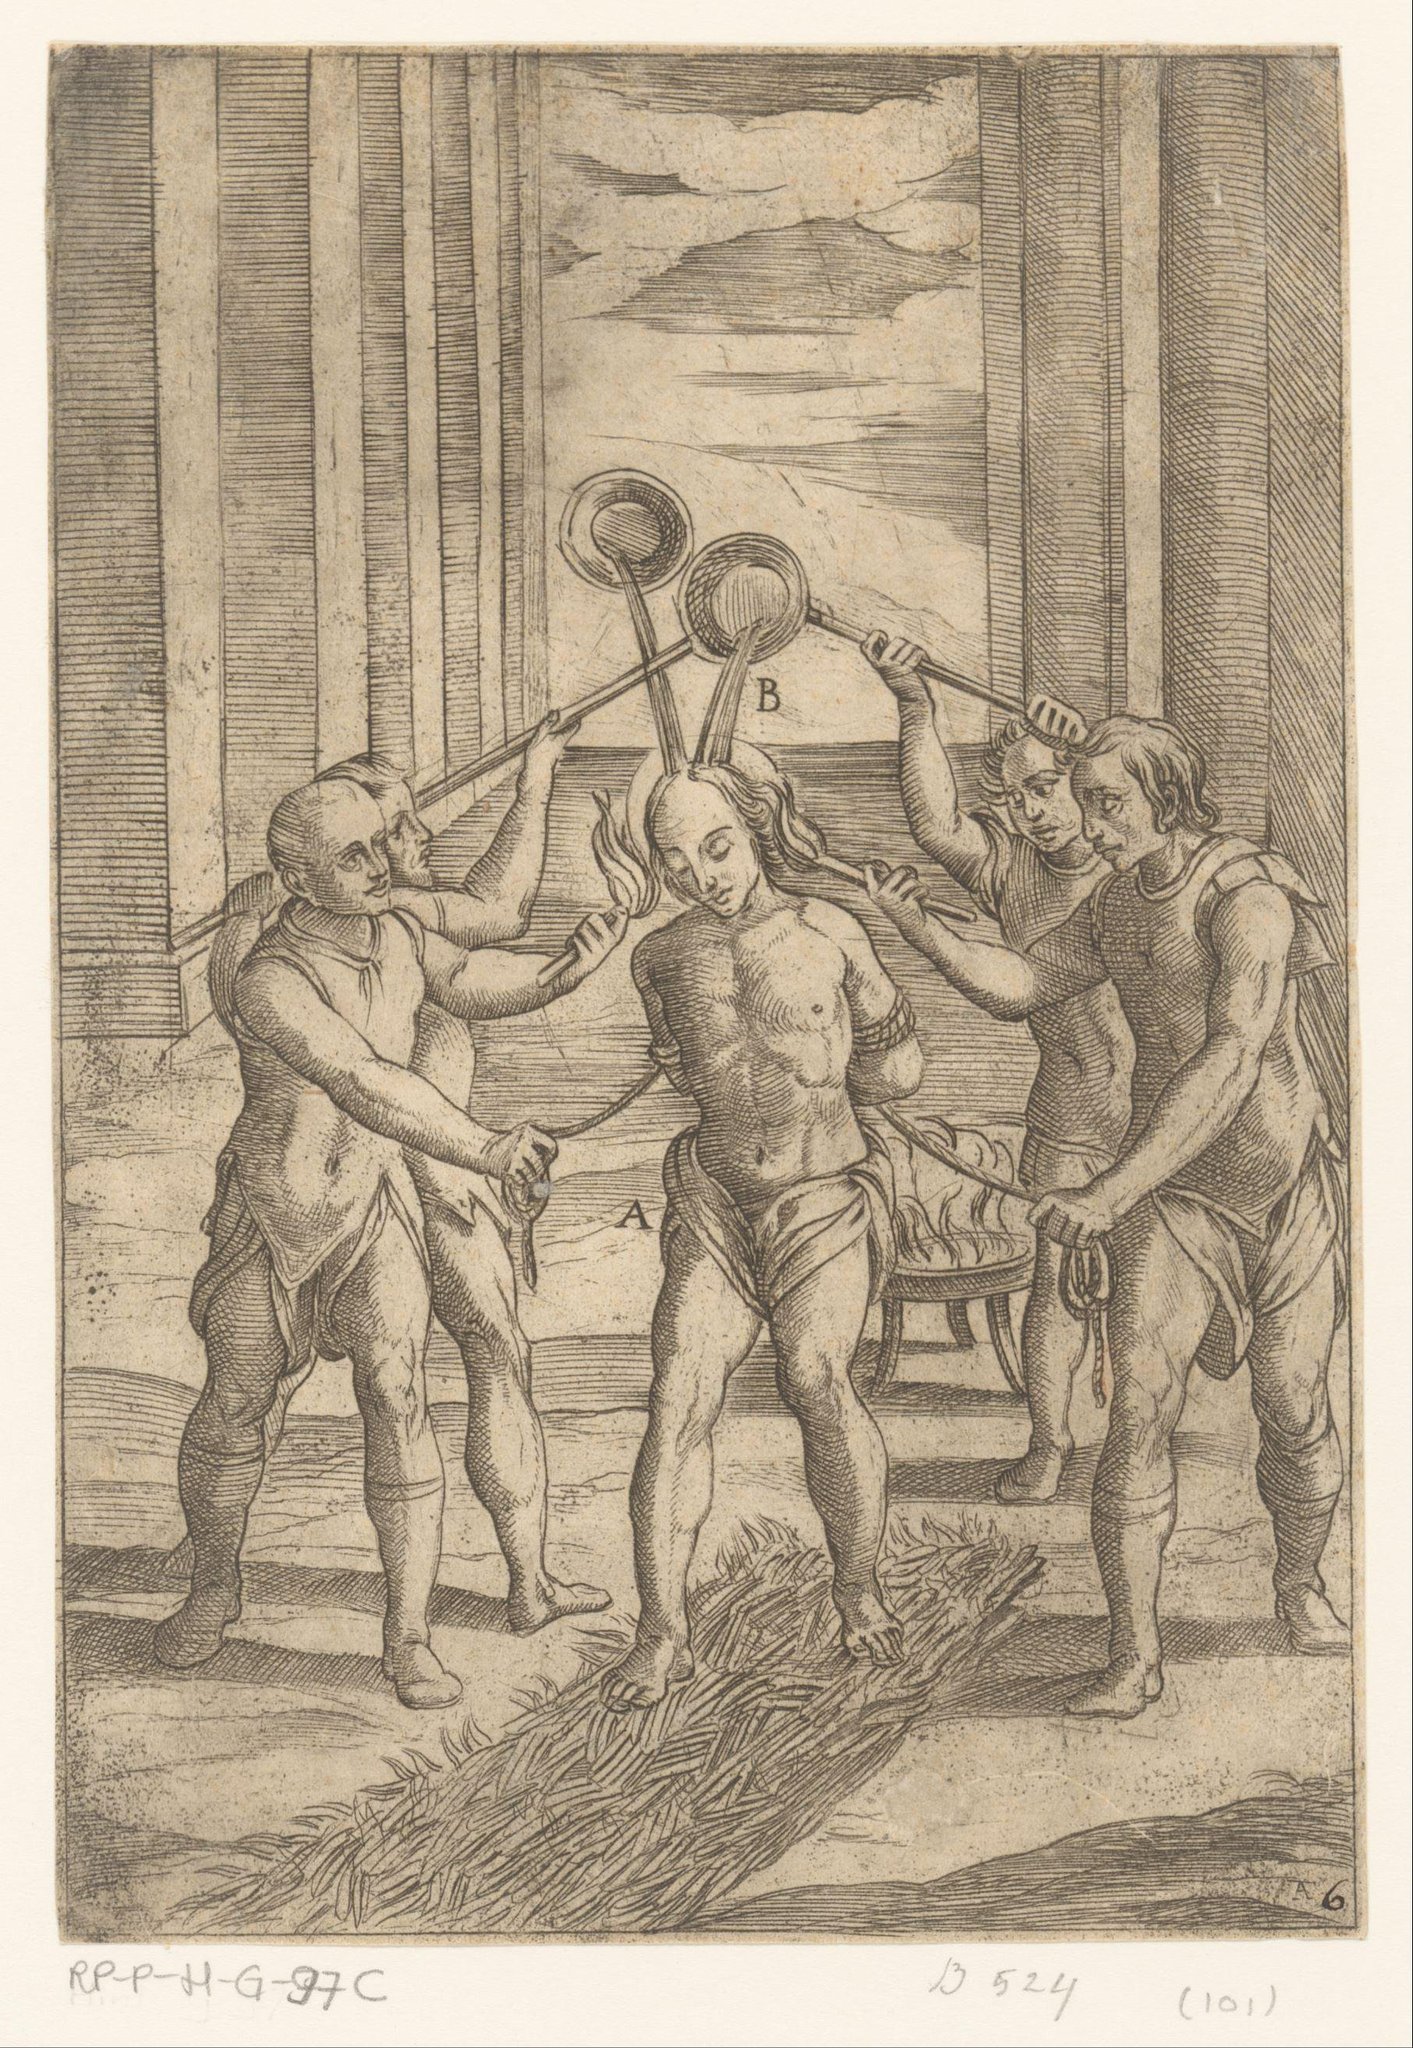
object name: print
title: Varia tormentorum et supplicioru crudelium (...)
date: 1565-1630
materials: paper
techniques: etching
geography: italy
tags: violent death ~ maltreatment, torture, torture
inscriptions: collector's mark: Lugt 11, number: ‘6’, collector's mark: ‘Hinloopen’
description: Deze prent maakt deel uit van een reeks van 47 prenten (+ titelprent) met voorstellingen van martelmethoden. Deze prenten zijn in een andere editie gebruikt als illustraties voor Antonio Gallonio's 'Trattato degli Instrumenti di Martirio e delle Varie Maniere di Martoriare Usate dai Gentili contro Christiani' (Rome, Ascanio en Girolamo Dongangeli, 1591). Midden onder nummer 101 weggekrast.